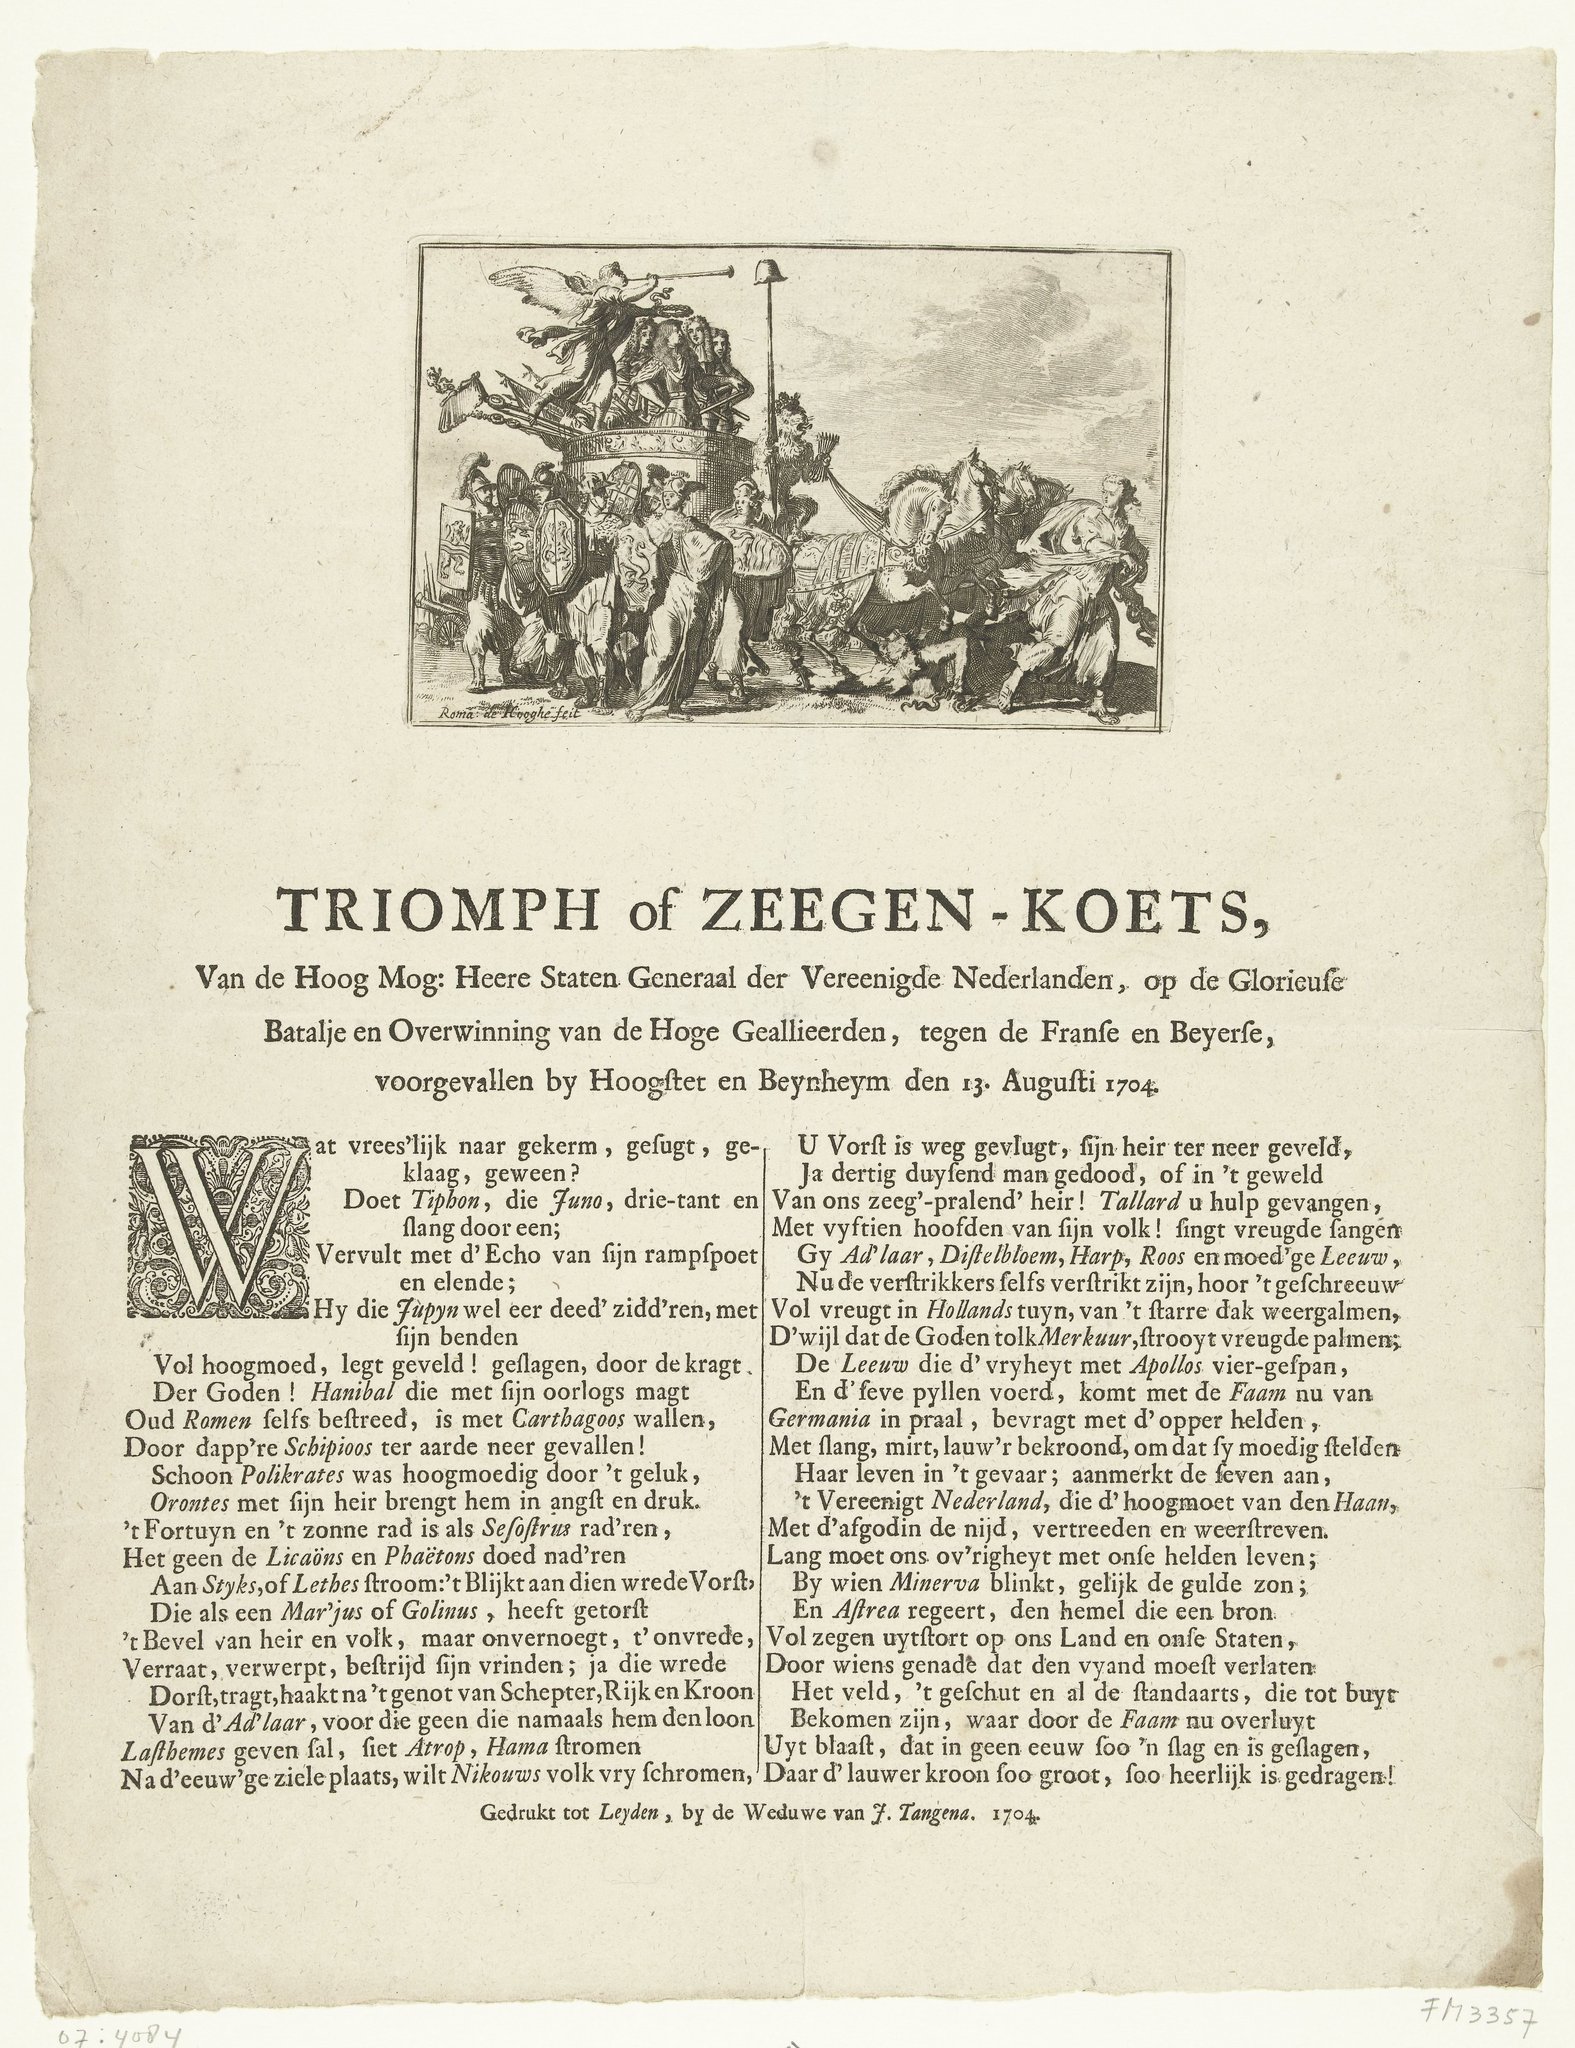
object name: print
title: Allegorie op overwinning bij Höchstädt, 1704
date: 1704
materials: paper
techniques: etching, letterpress printing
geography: northern netherlands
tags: vienna, eugenius van savoye, john churchill (1e hertog van marlborough), chariot, triumphal car, fame; 'fama', 'fama buona', 'fama chiara' (ripa)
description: Allegorie op overwinning bij Höchstädt en Blenheim, 13 augustus 1704. Triomfwagen met de overwinnende geallieerde legeraanvoerders, met Faam en de Nederlandse Leeuw. Hiervoor personificaties van de zeven provincies van de Republiek. Gedrukt op het blad onder de plaat een vers in 2 kolommen in het Nederlands.